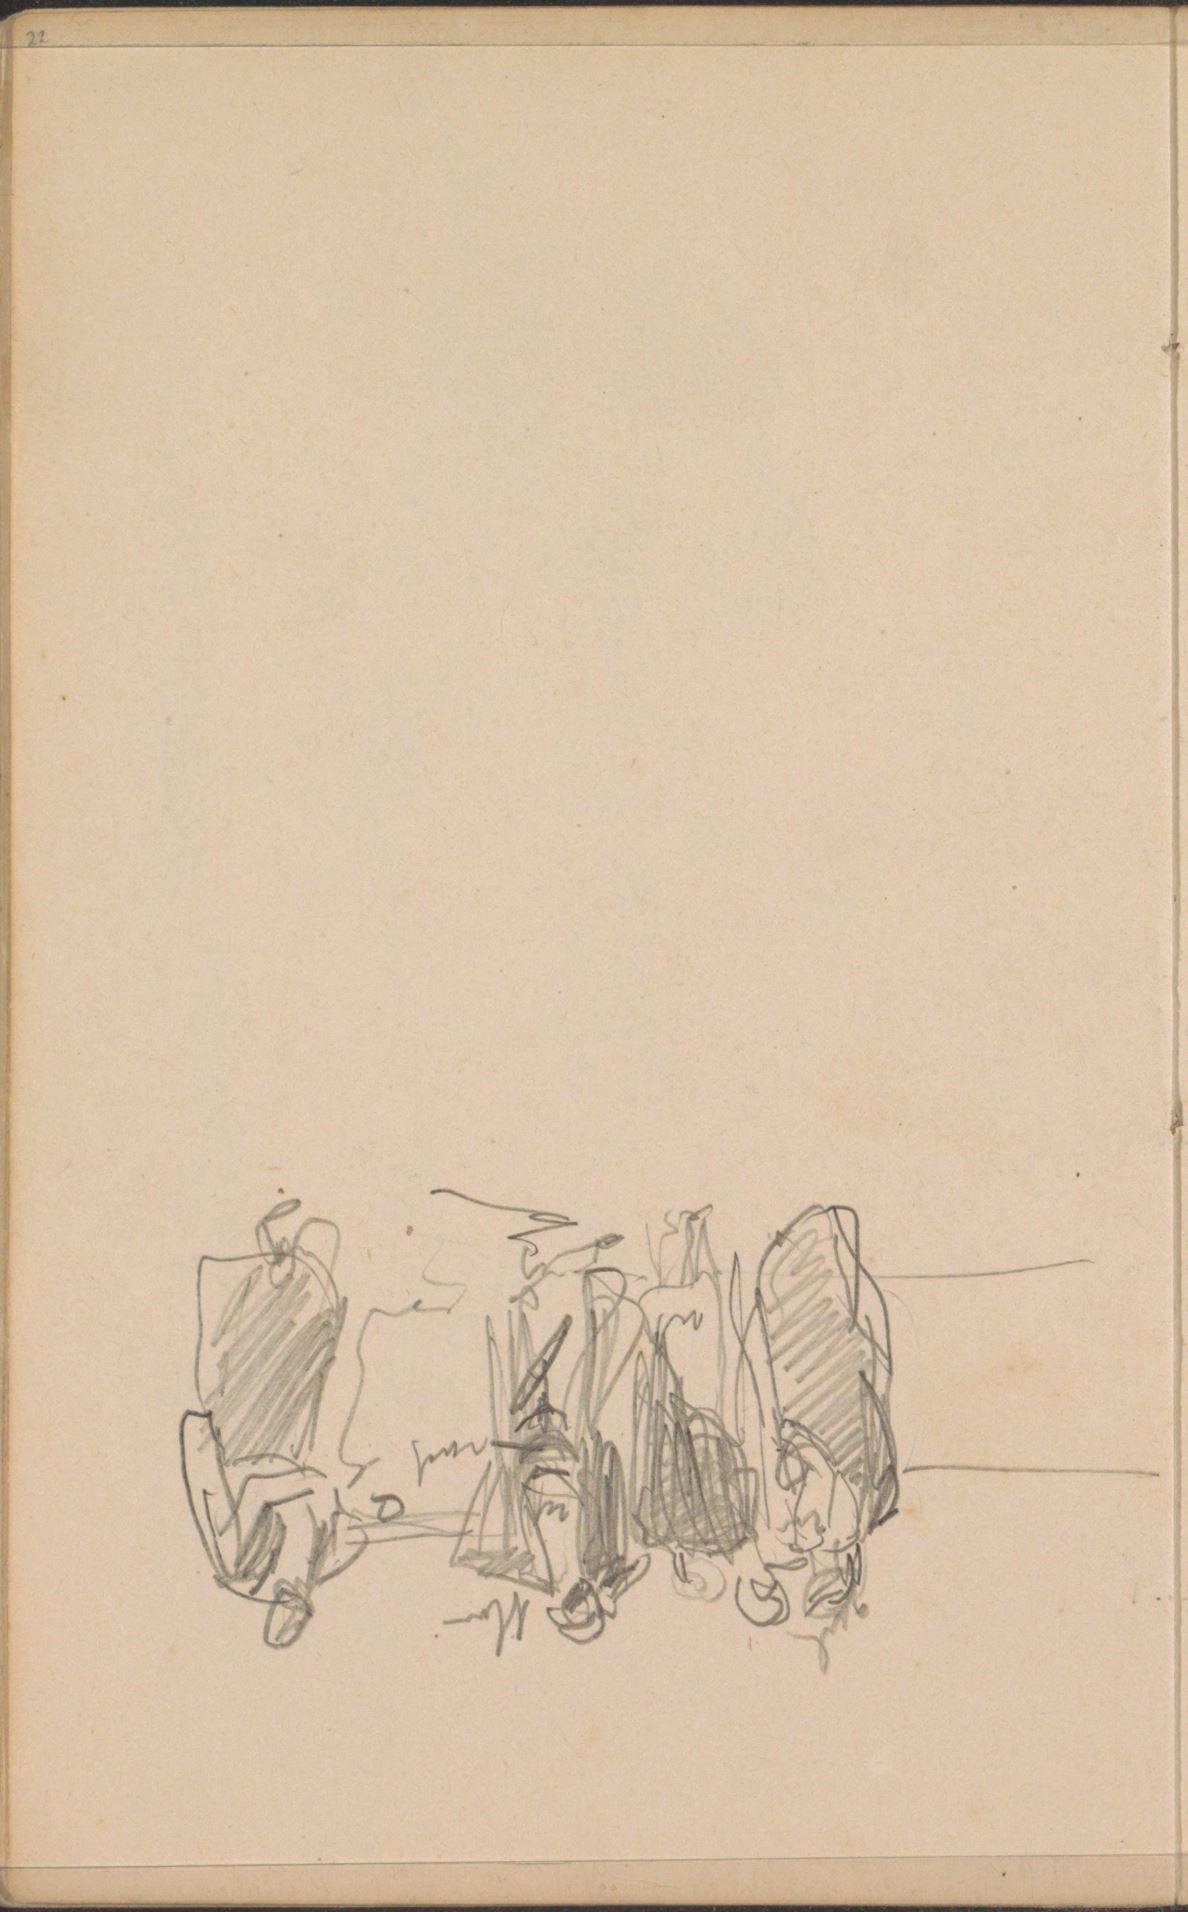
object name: sketchbook leaf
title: Vijf Arabieren bij een muur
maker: marius bauer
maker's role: draughtsman, print maker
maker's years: 1867-1932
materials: paper, pencil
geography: jerusalem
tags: africans, folk costume, regional costume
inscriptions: kleurnotitie, handgeschreven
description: De mannen dragen traditioneel kostuum. Pagina 22 uit een schetsboek met 36 bladen.